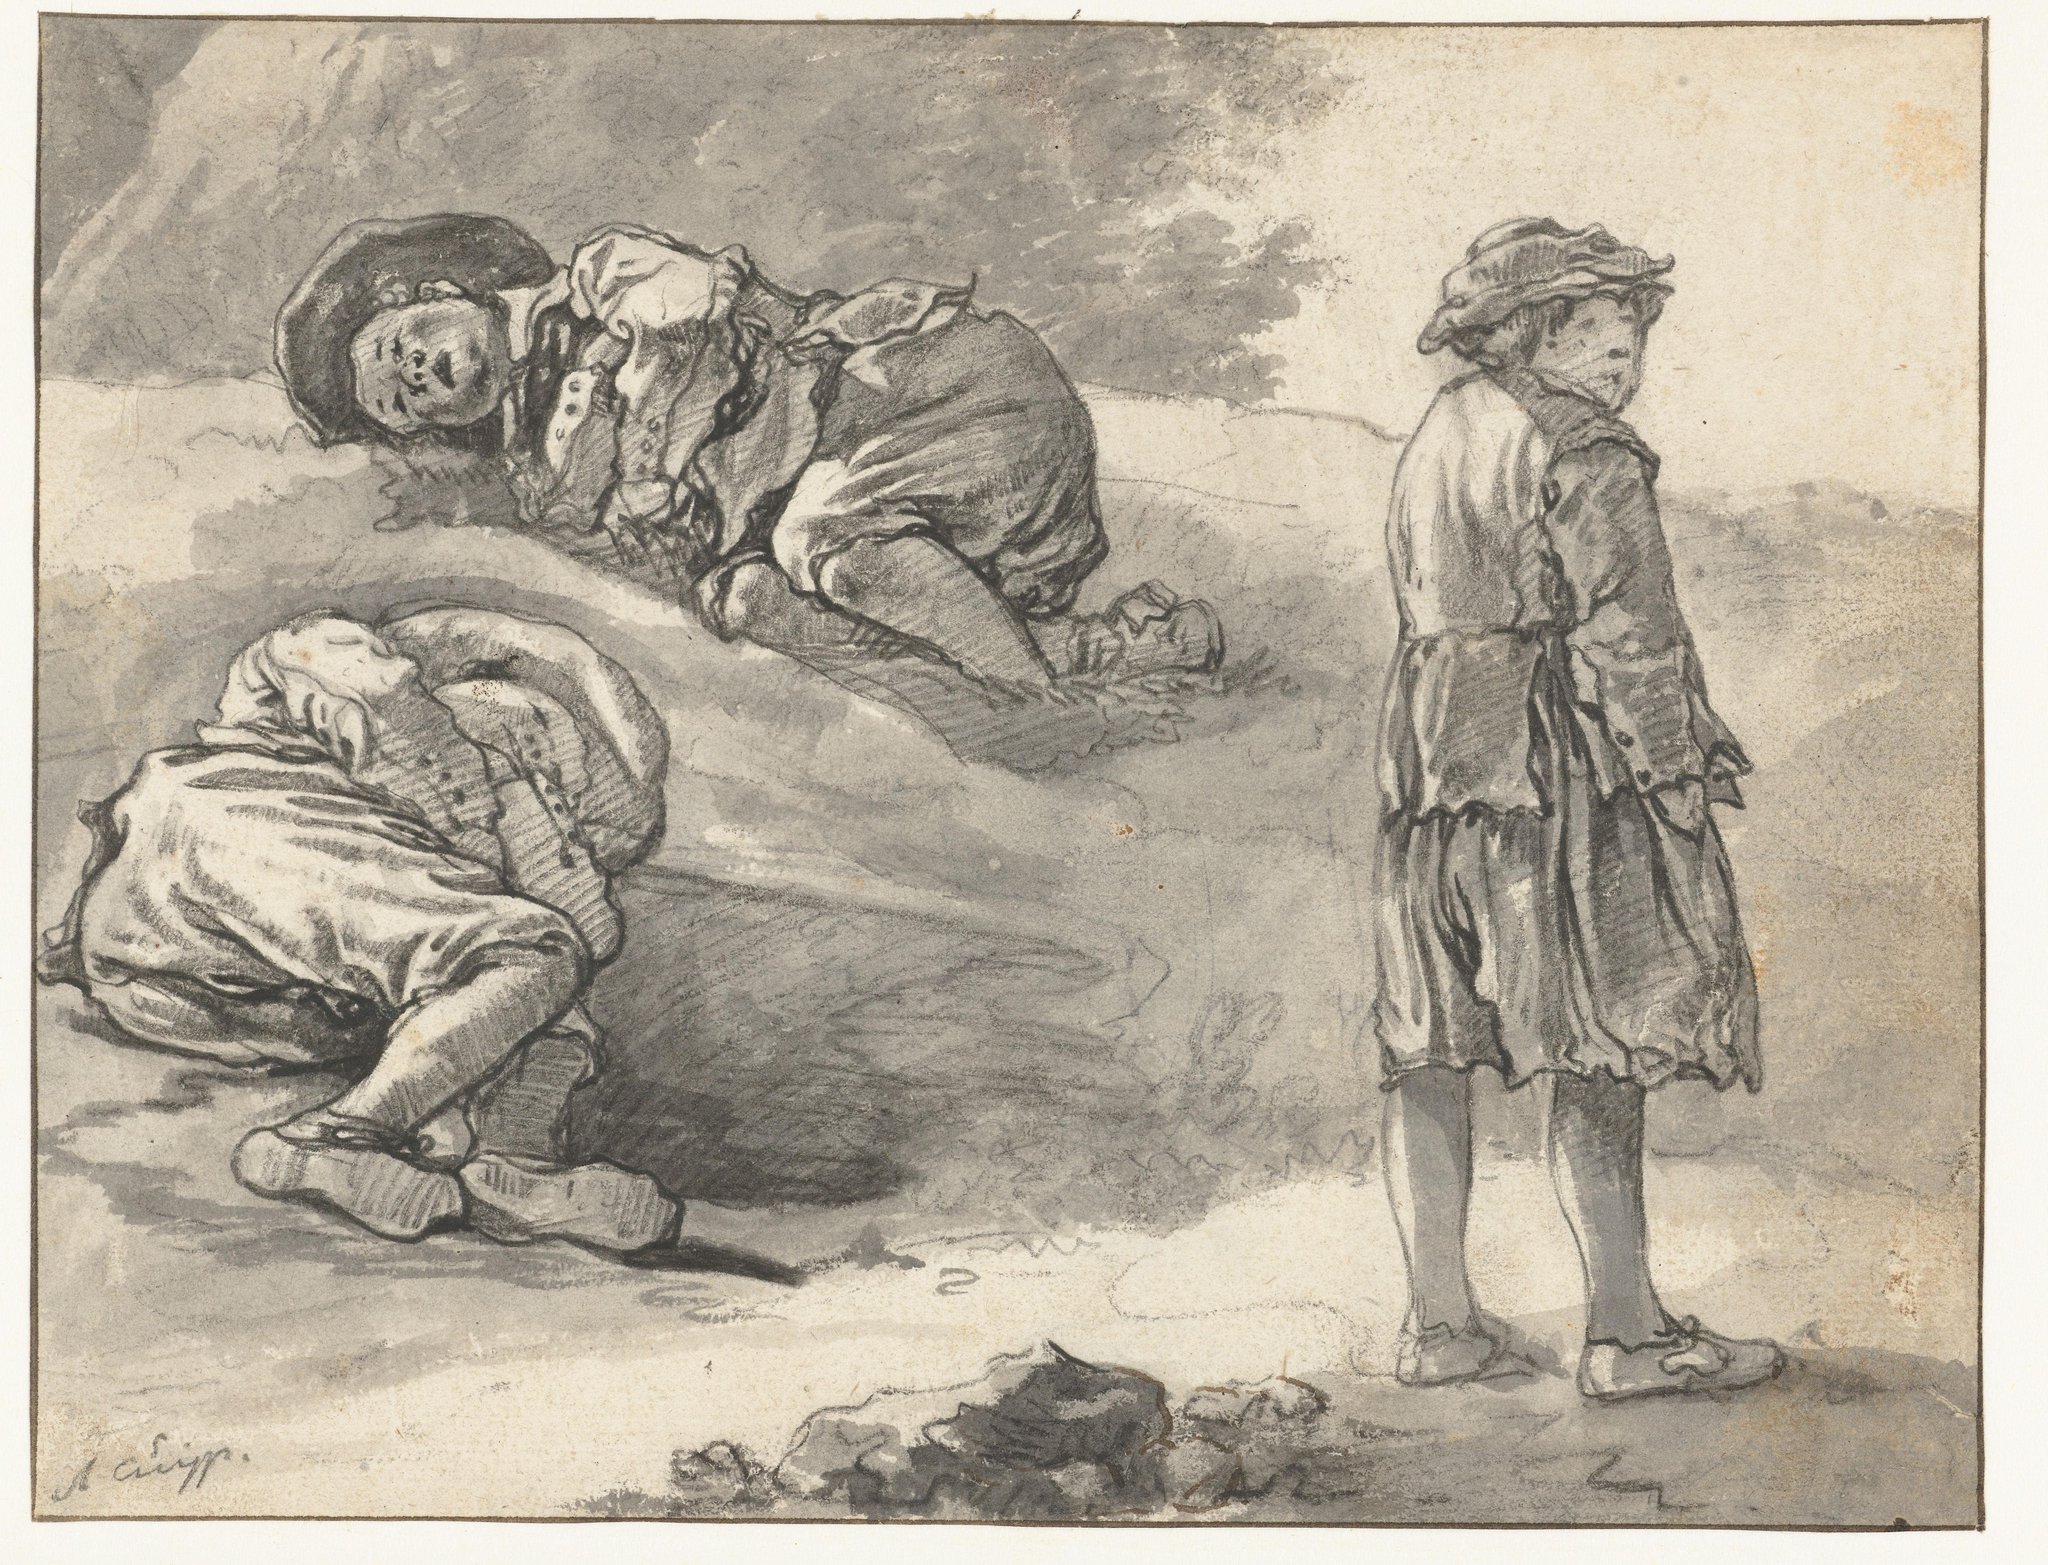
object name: drawing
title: Three Studies of a little Shepherd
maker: aelbert cuyp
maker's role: draughtsman, painter, print maker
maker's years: 1620-1691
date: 1630-1691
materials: chalk, paper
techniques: brush